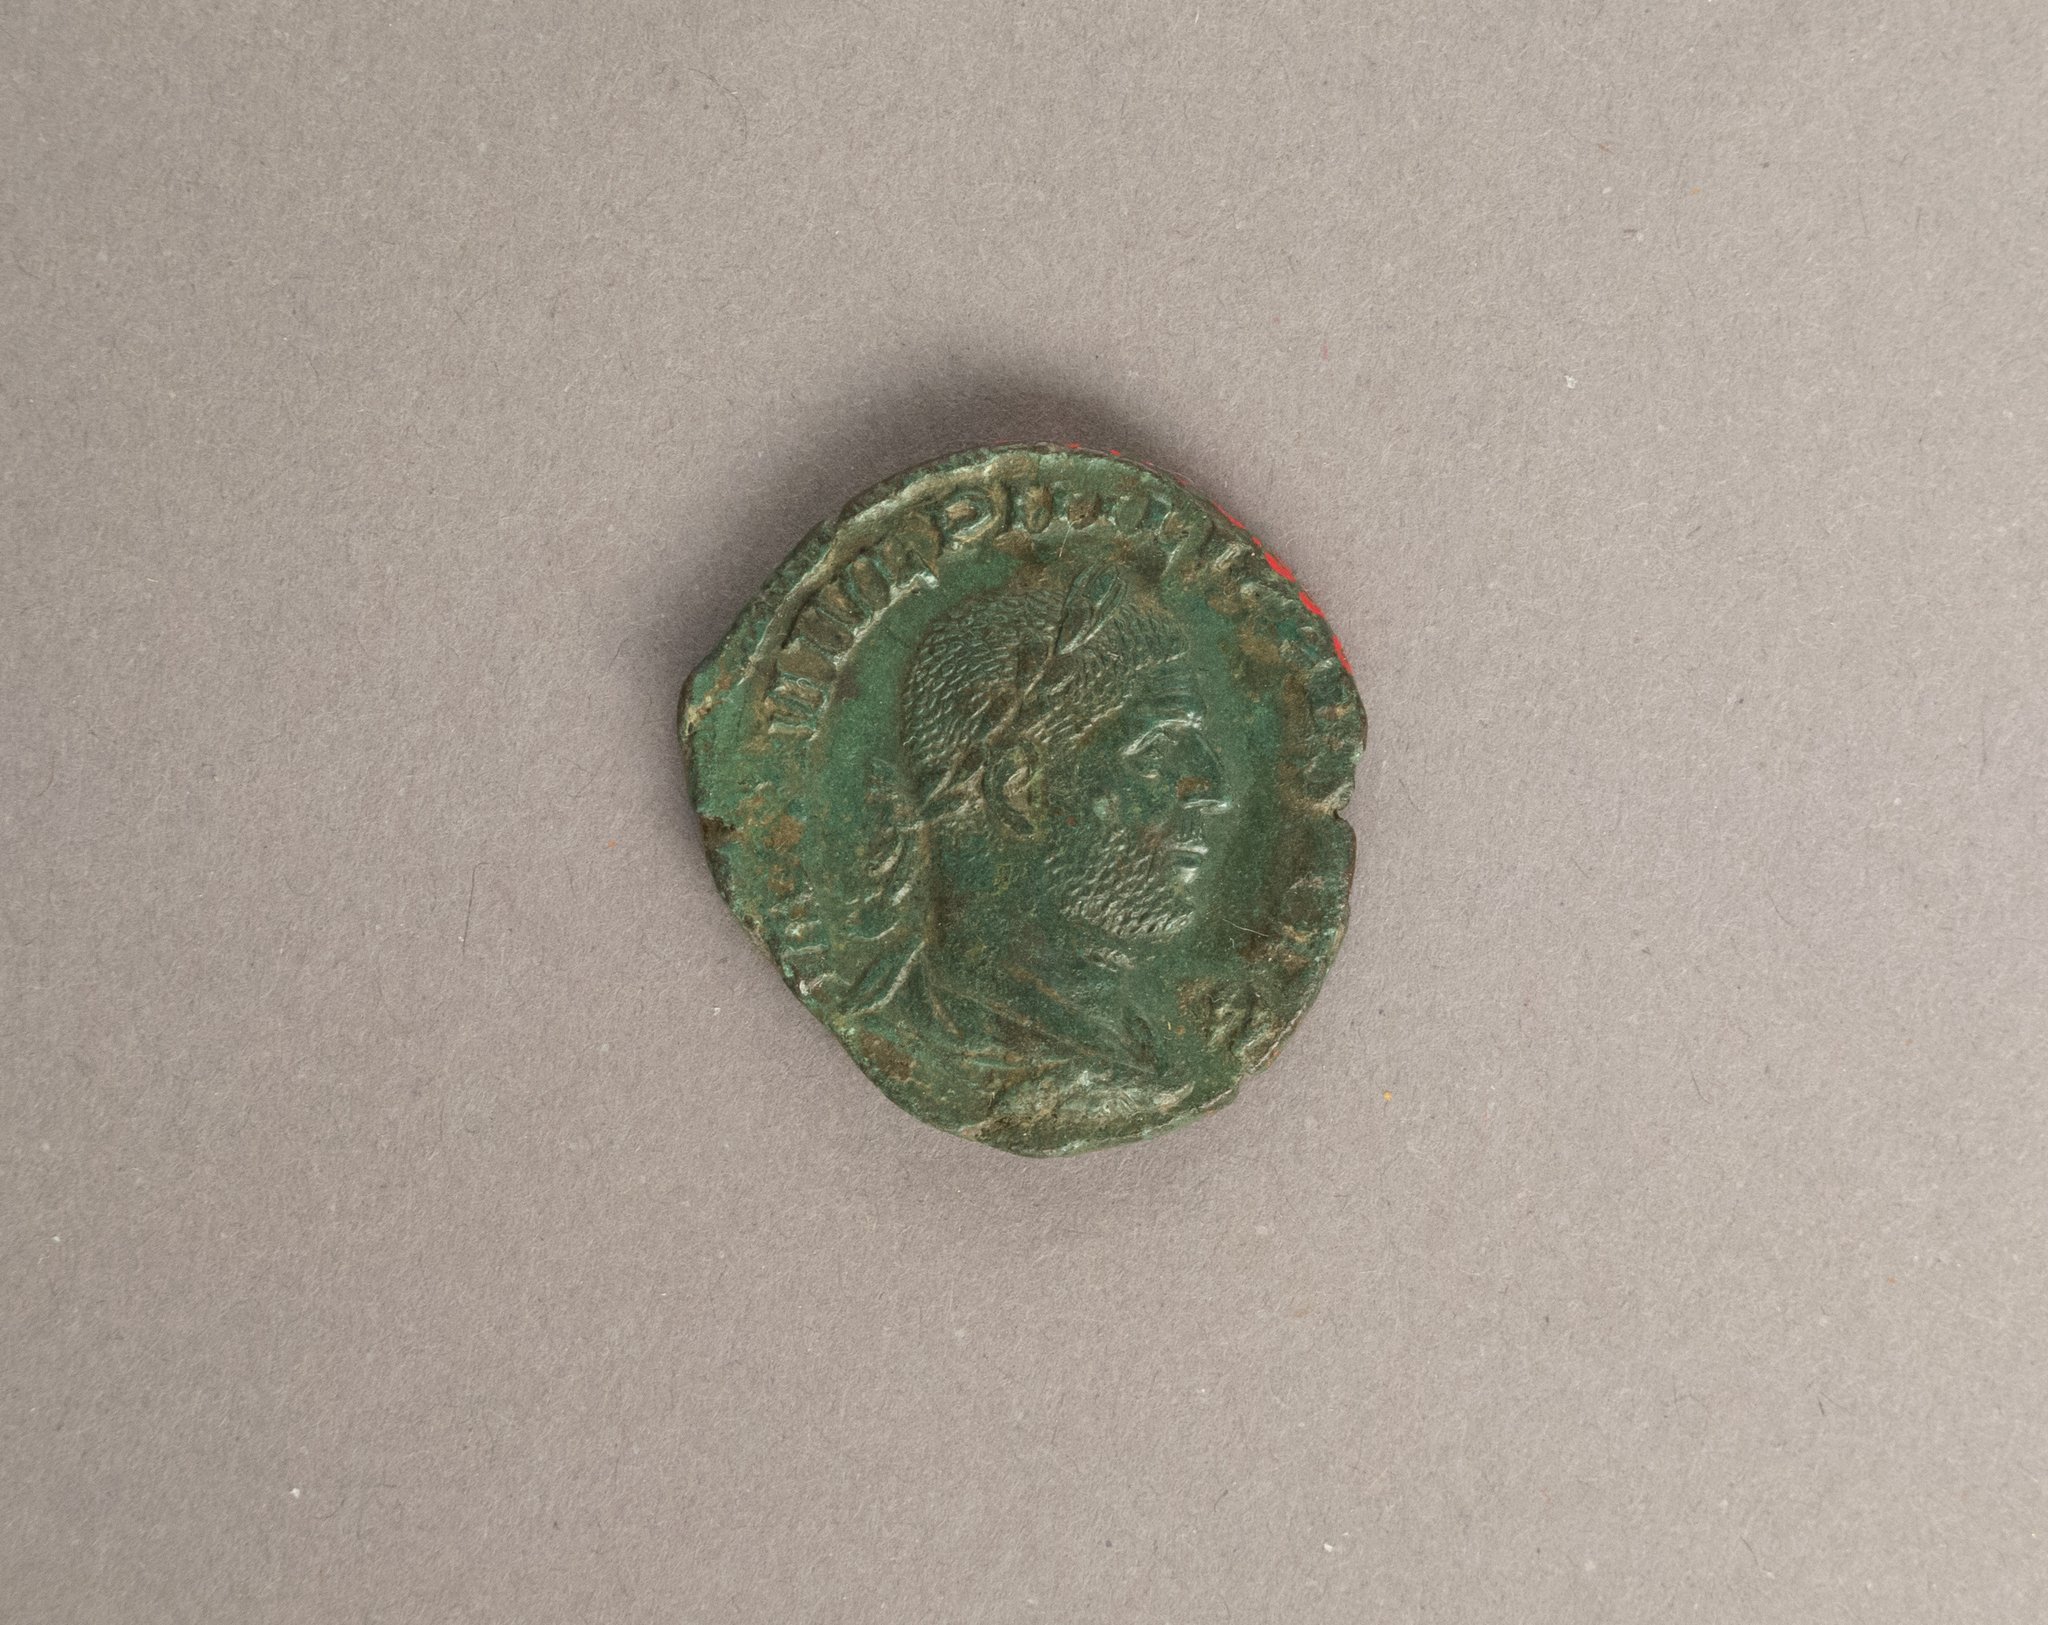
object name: sestertius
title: Bronze sesterius of Philip I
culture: roman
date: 244-249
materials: bronze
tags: men,profiles